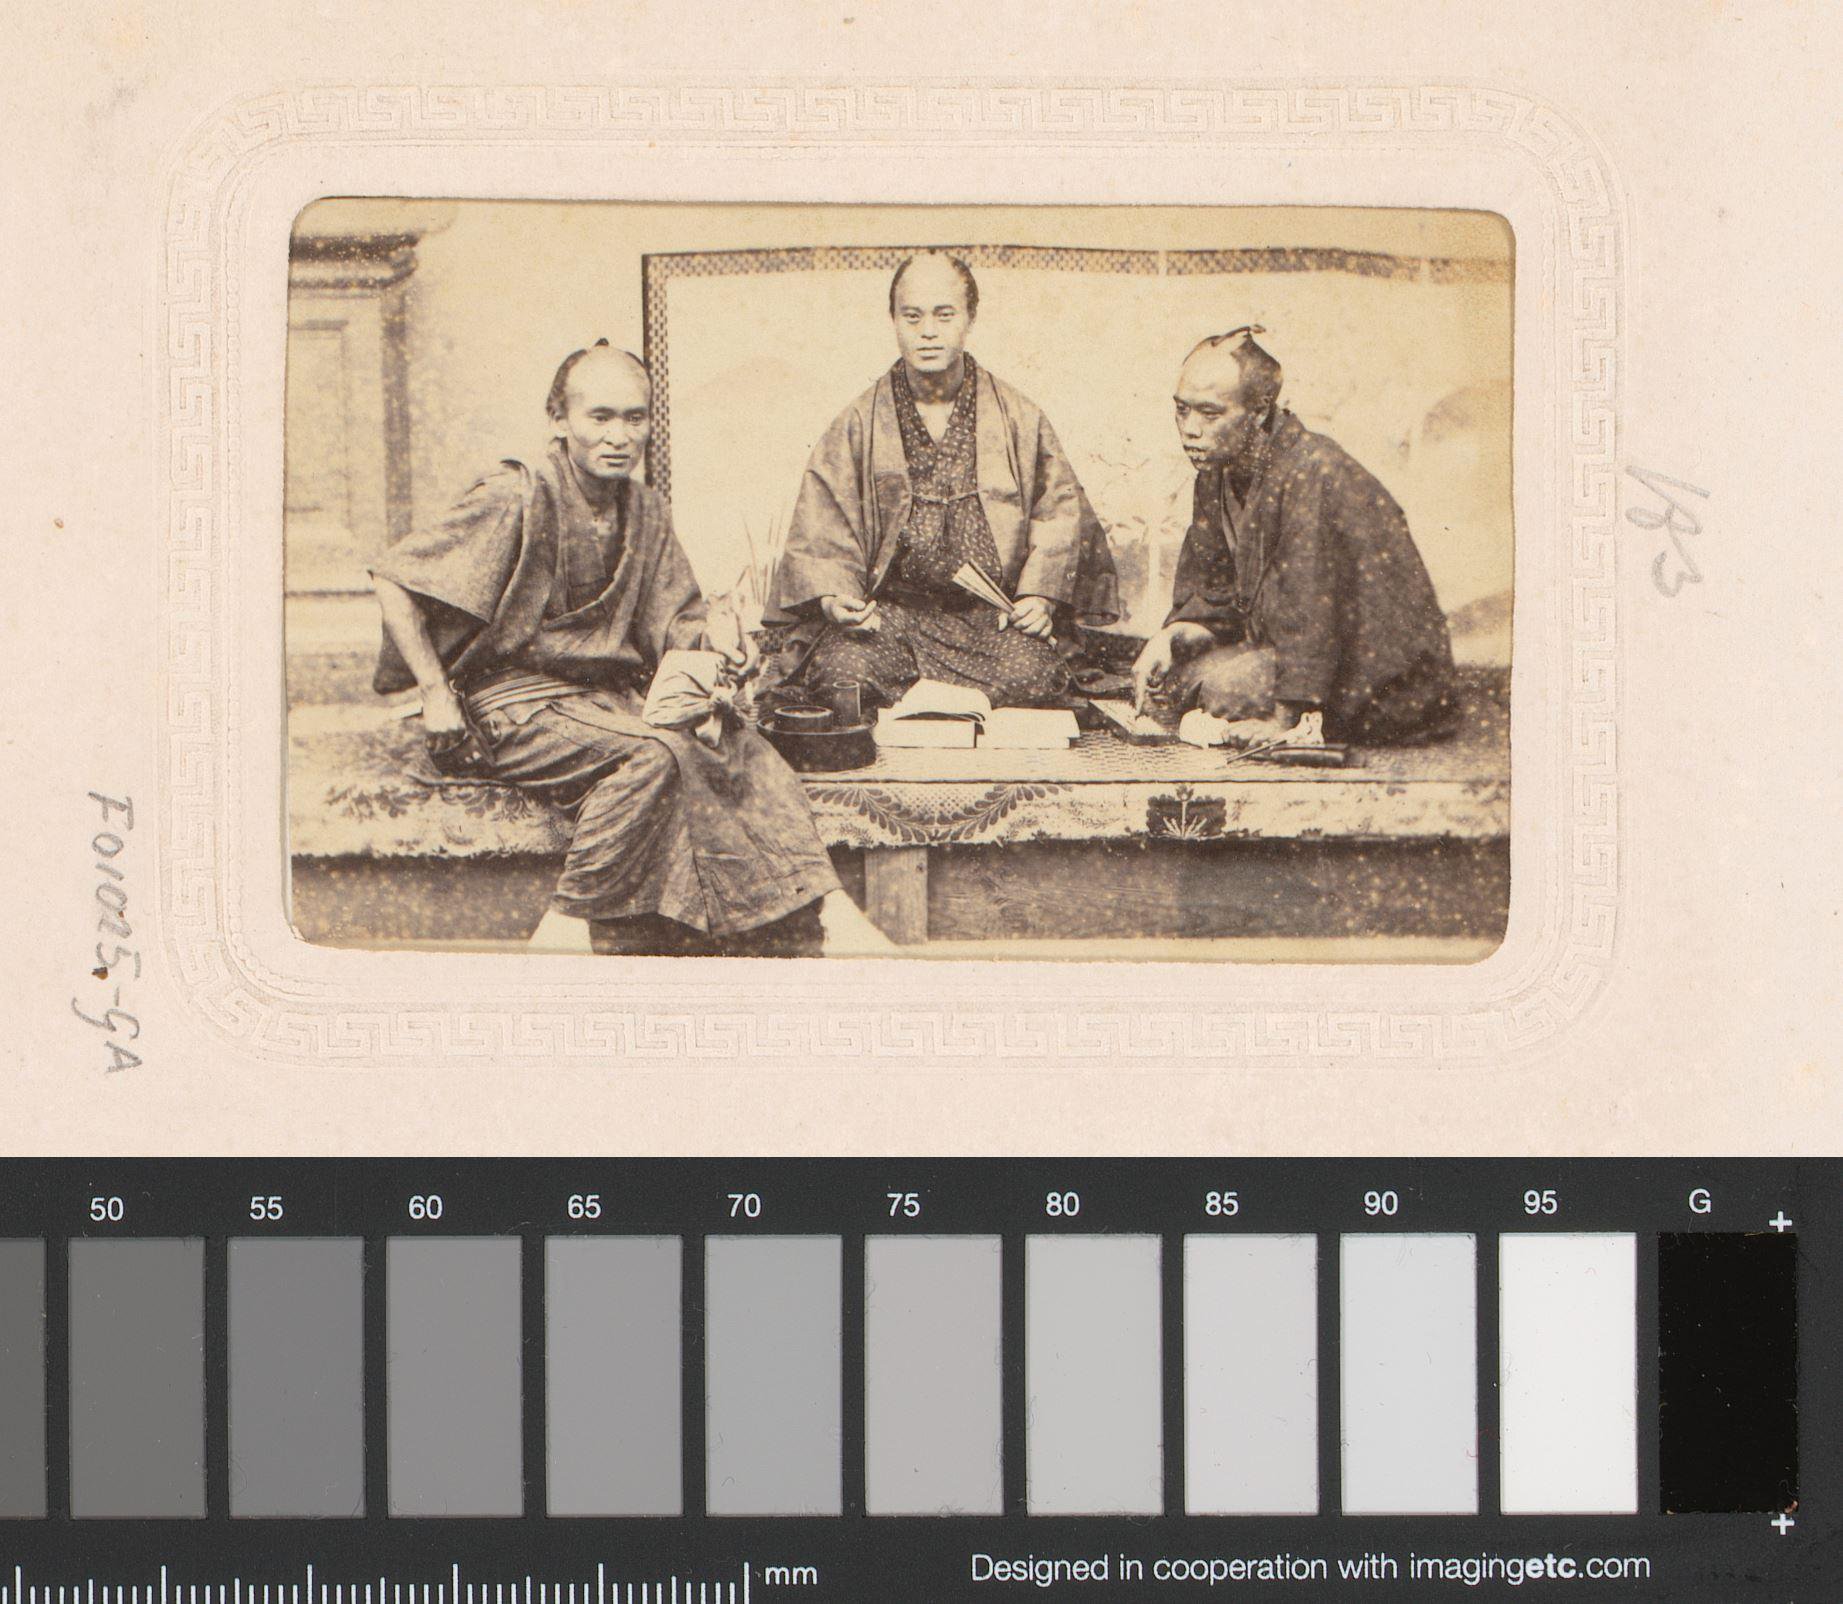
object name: photograph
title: Portret van drie Japanse mannen met telraam en boek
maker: Anonymous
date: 1850-1880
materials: cardboard, photographic support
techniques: albumen print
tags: abacus, counting-frame, anonymous historical persons portrayed in a group, in a group-portrait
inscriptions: number: ‘183’